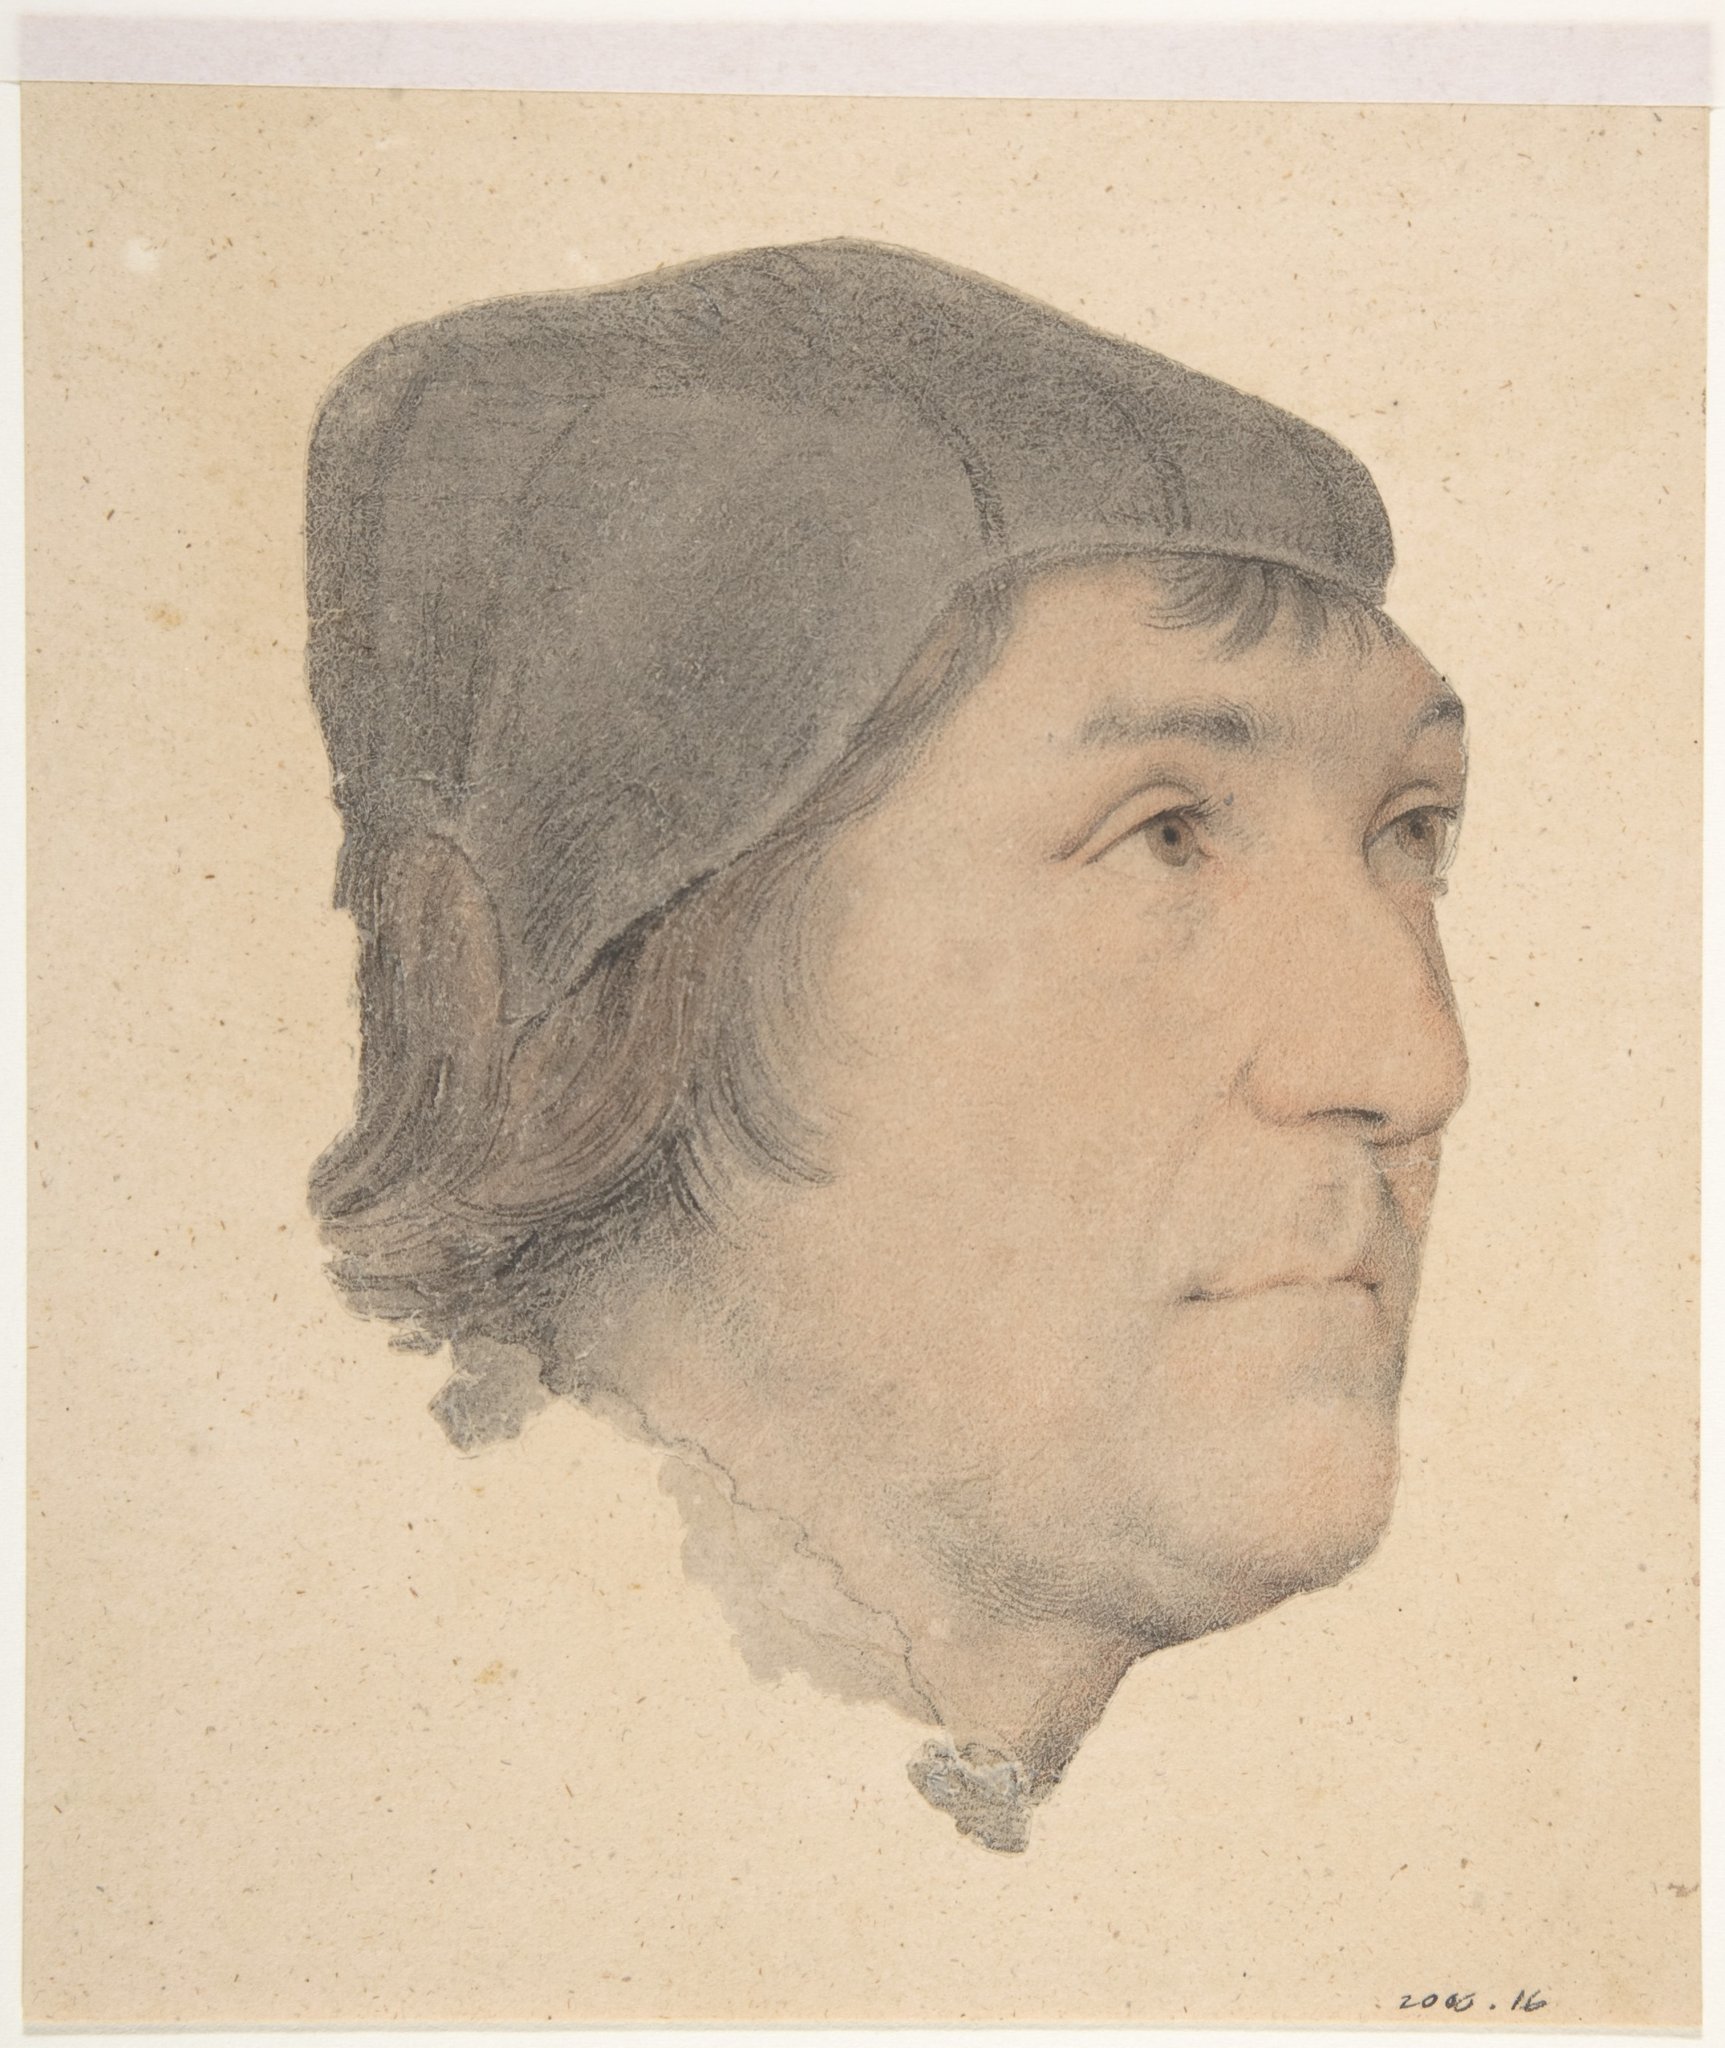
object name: drawing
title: Portrait of John Poyntz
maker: hans holbein the younger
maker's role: artist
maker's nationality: german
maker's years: 1497-1543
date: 1501-1533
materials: chalk, ink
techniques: brush, stumping, wash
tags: men,portraits